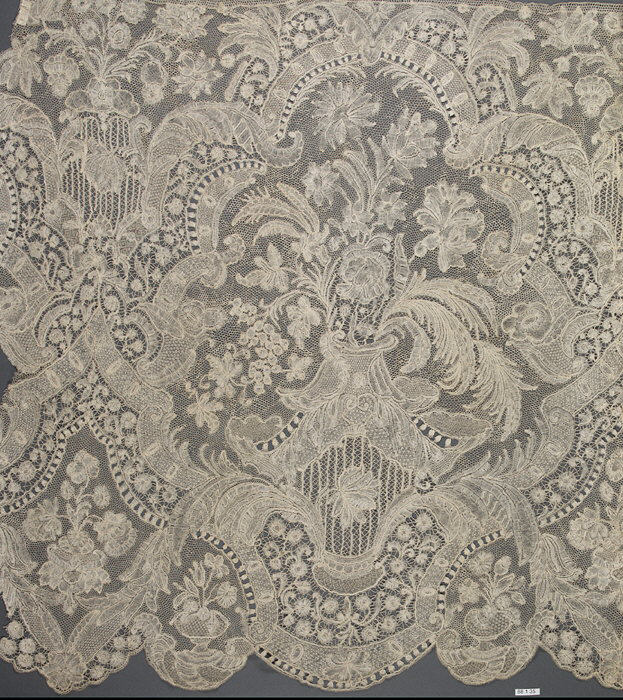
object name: flounce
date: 1701-1800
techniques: lace